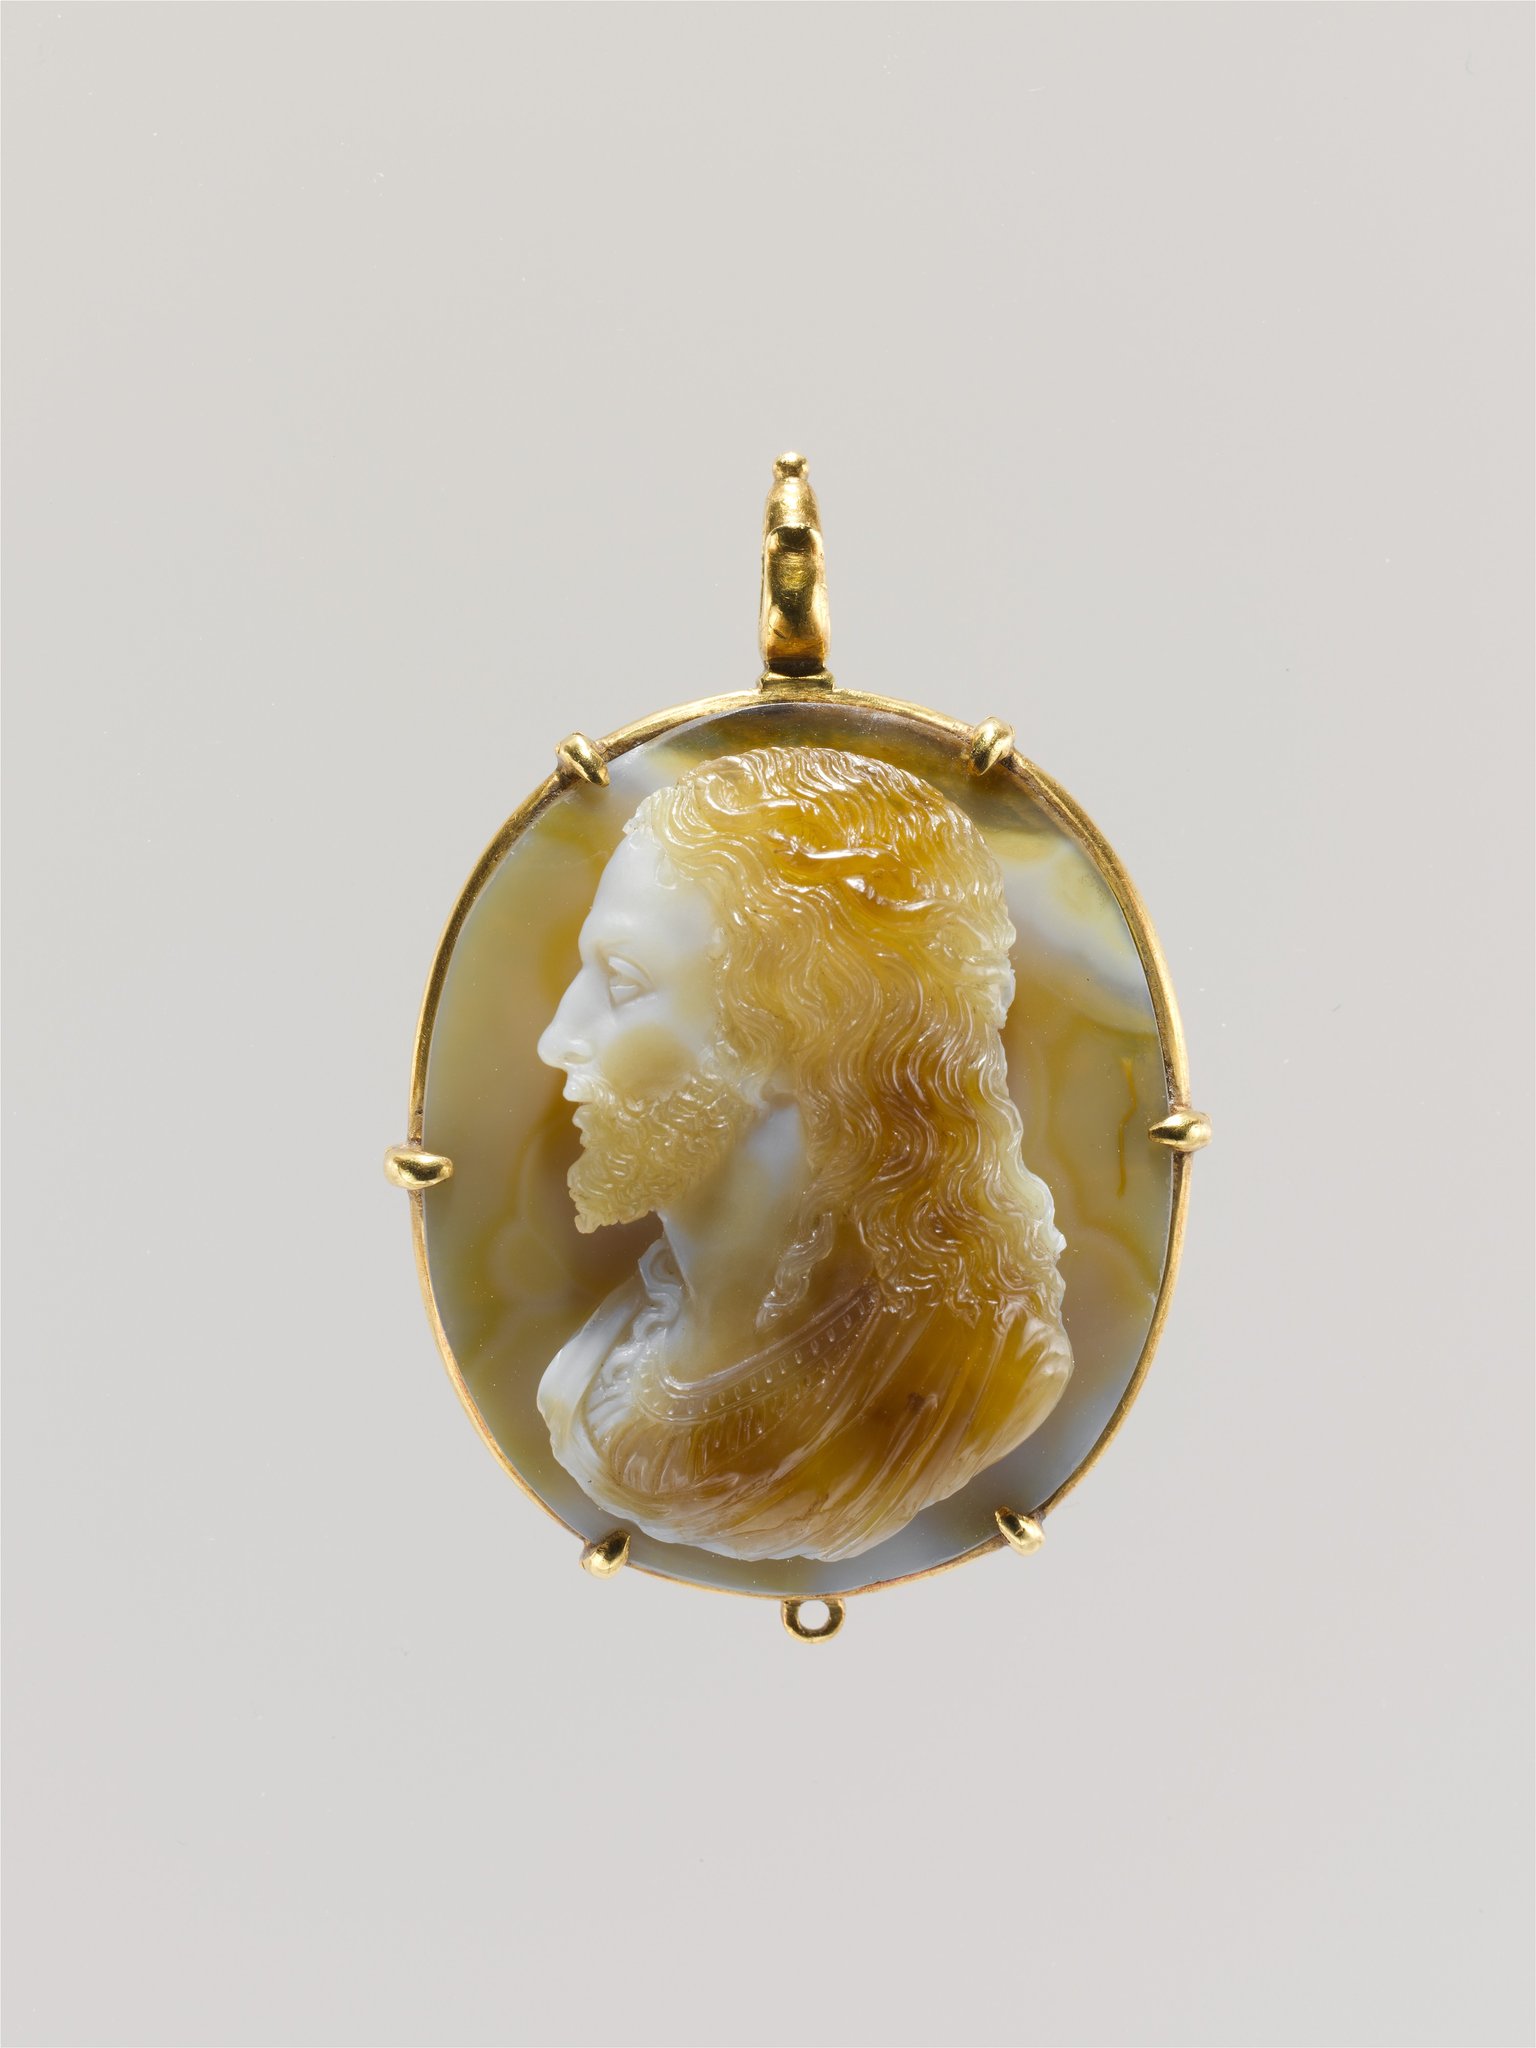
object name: cameo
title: Bust of Christ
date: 1600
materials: gold, onyx, gemstone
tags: christ